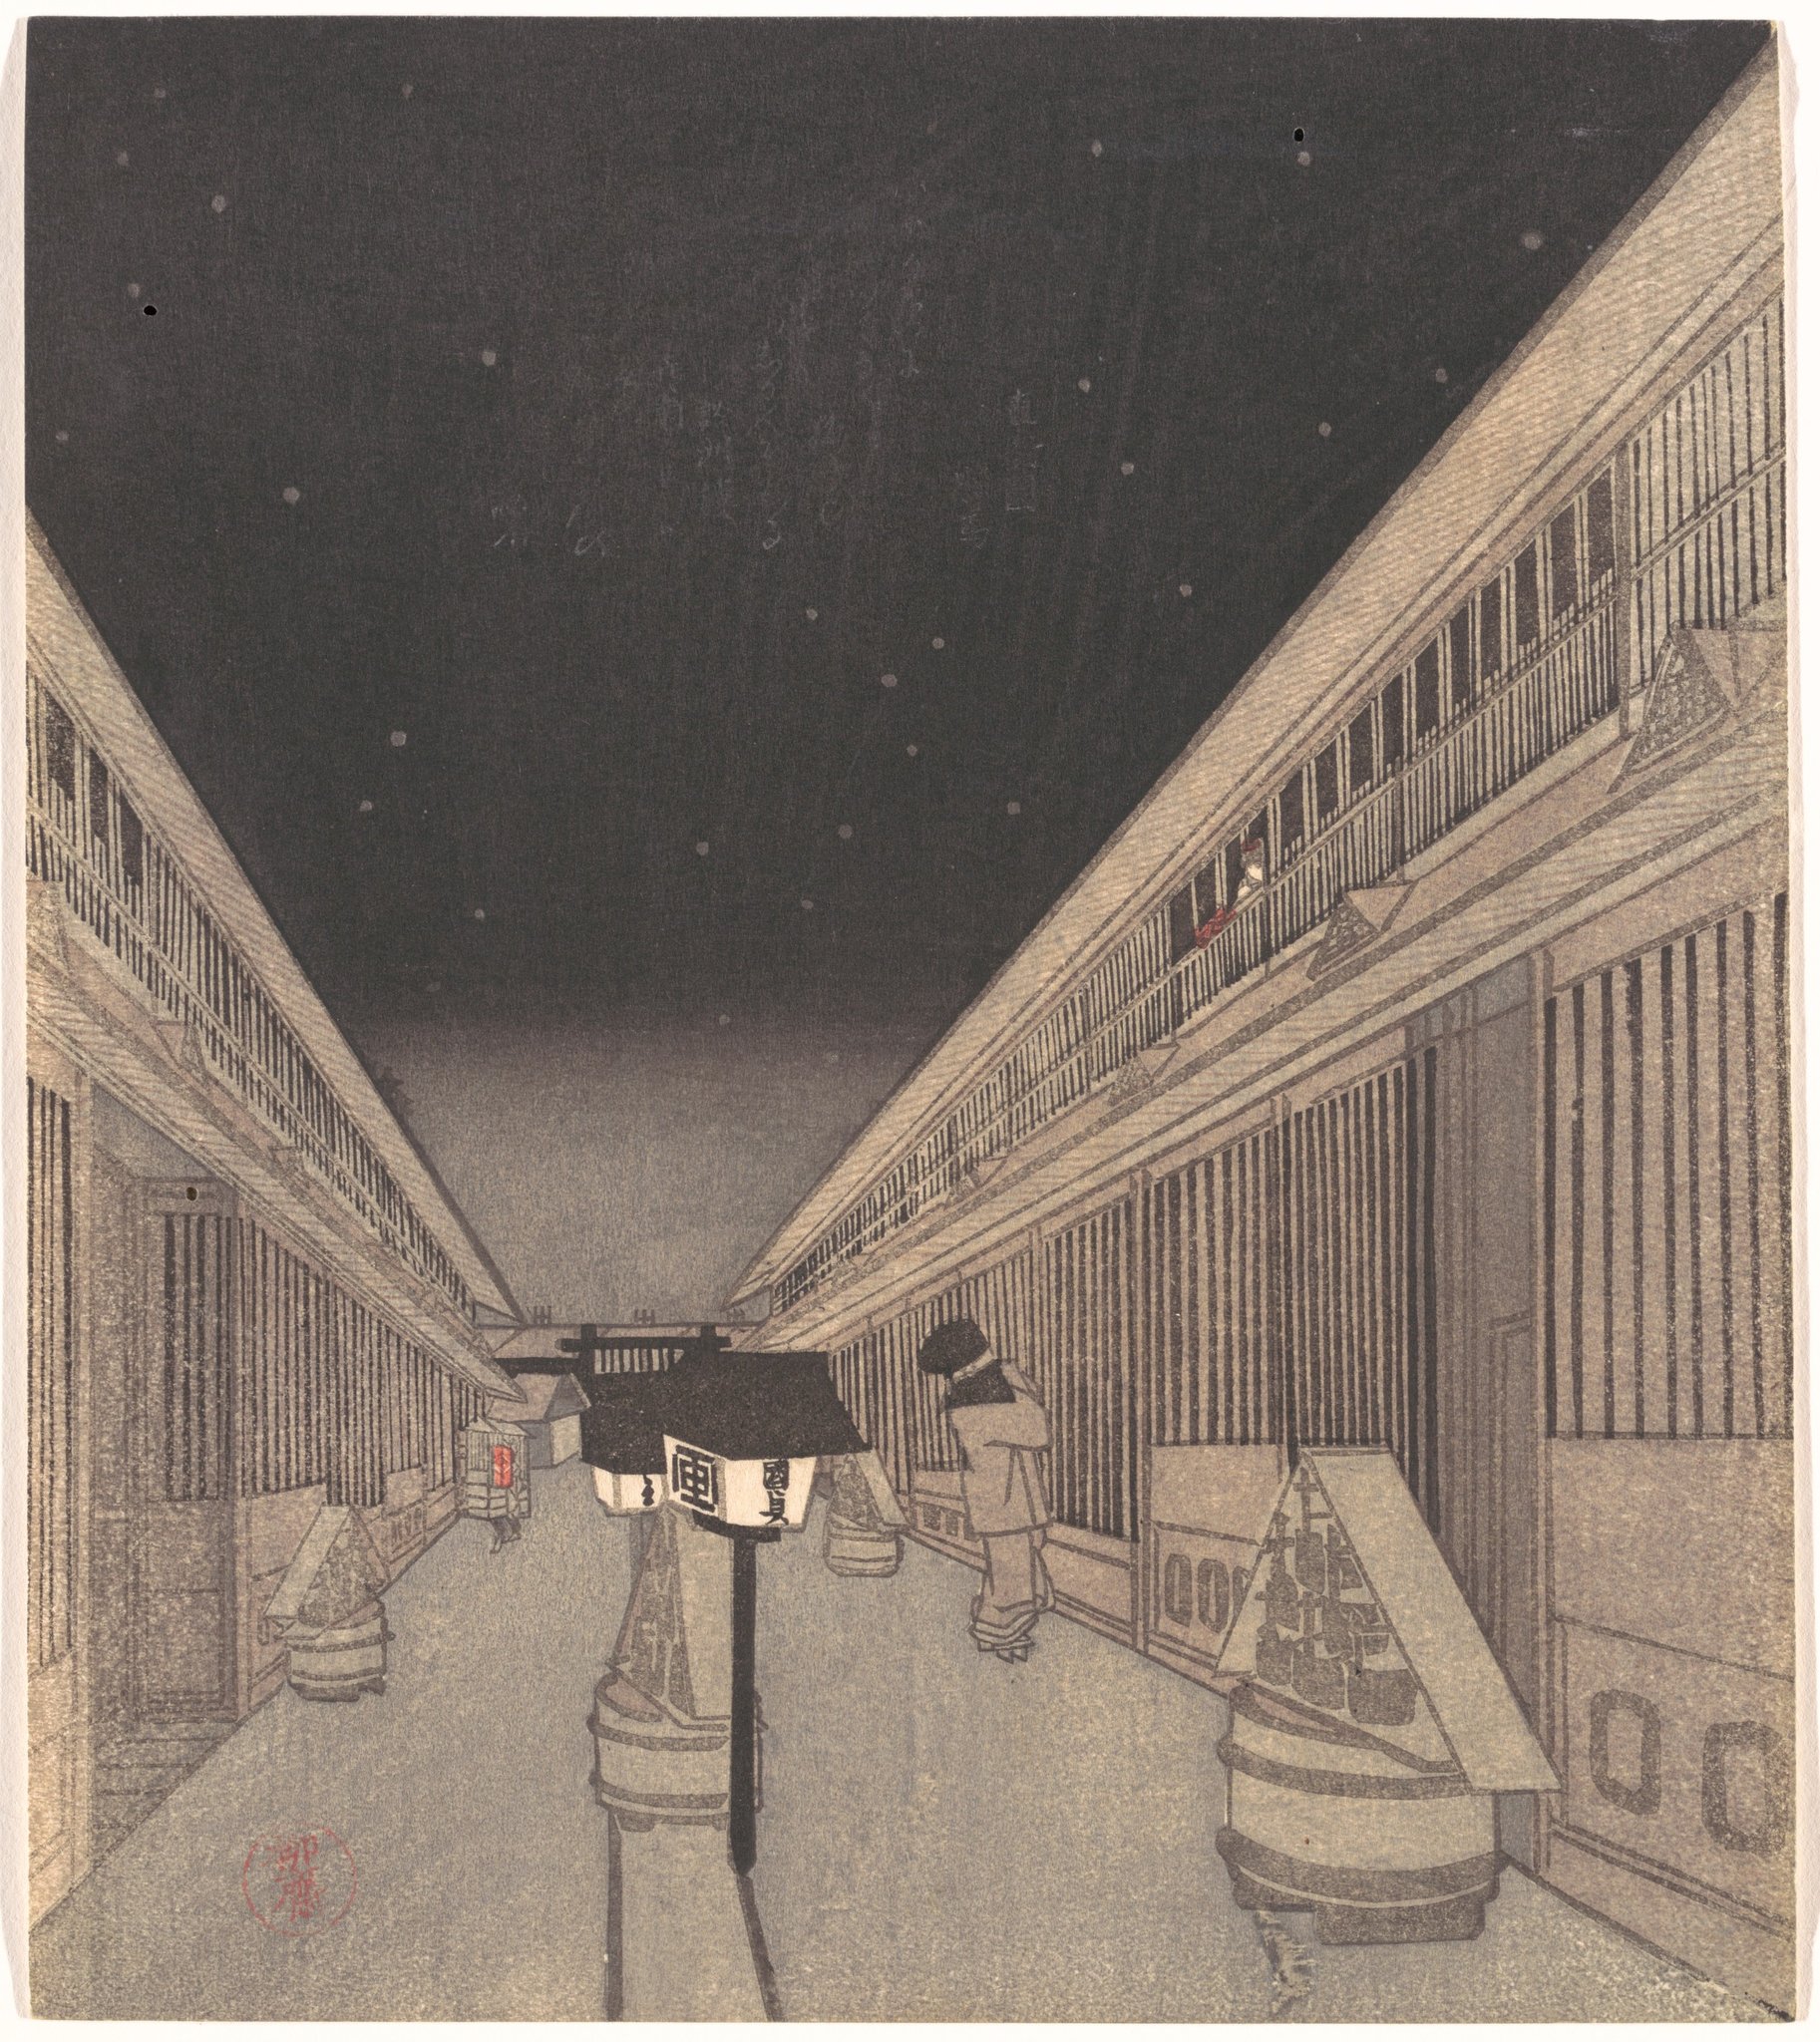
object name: print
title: Main Street of the Yoshiwara on a Starlight Night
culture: japanese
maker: utagawa kunisada ii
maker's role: artist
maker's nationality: japanese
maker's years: 1823-1880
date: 1852-1864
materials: ink, paper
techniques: surimono, woodblock print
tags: streets,night